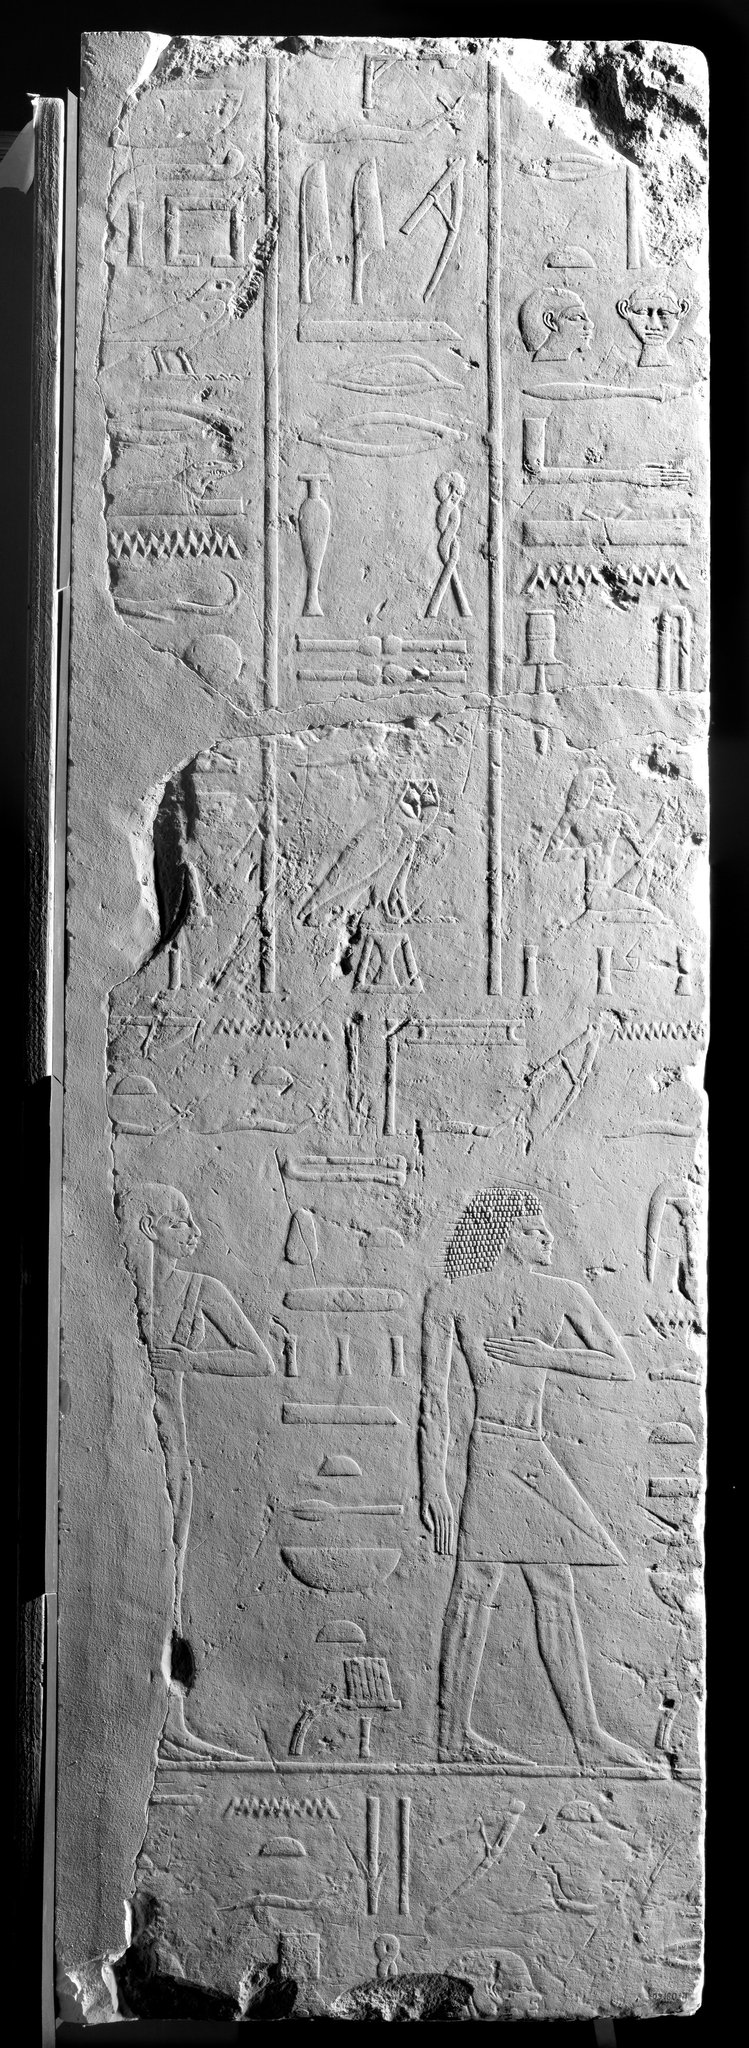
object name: relief, tomb of sebeknakht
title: Relief block from the tomb of Sebeknakht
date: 1971-1952 BCE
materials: limestone, paint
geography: egypt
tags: men,hieroglyphs